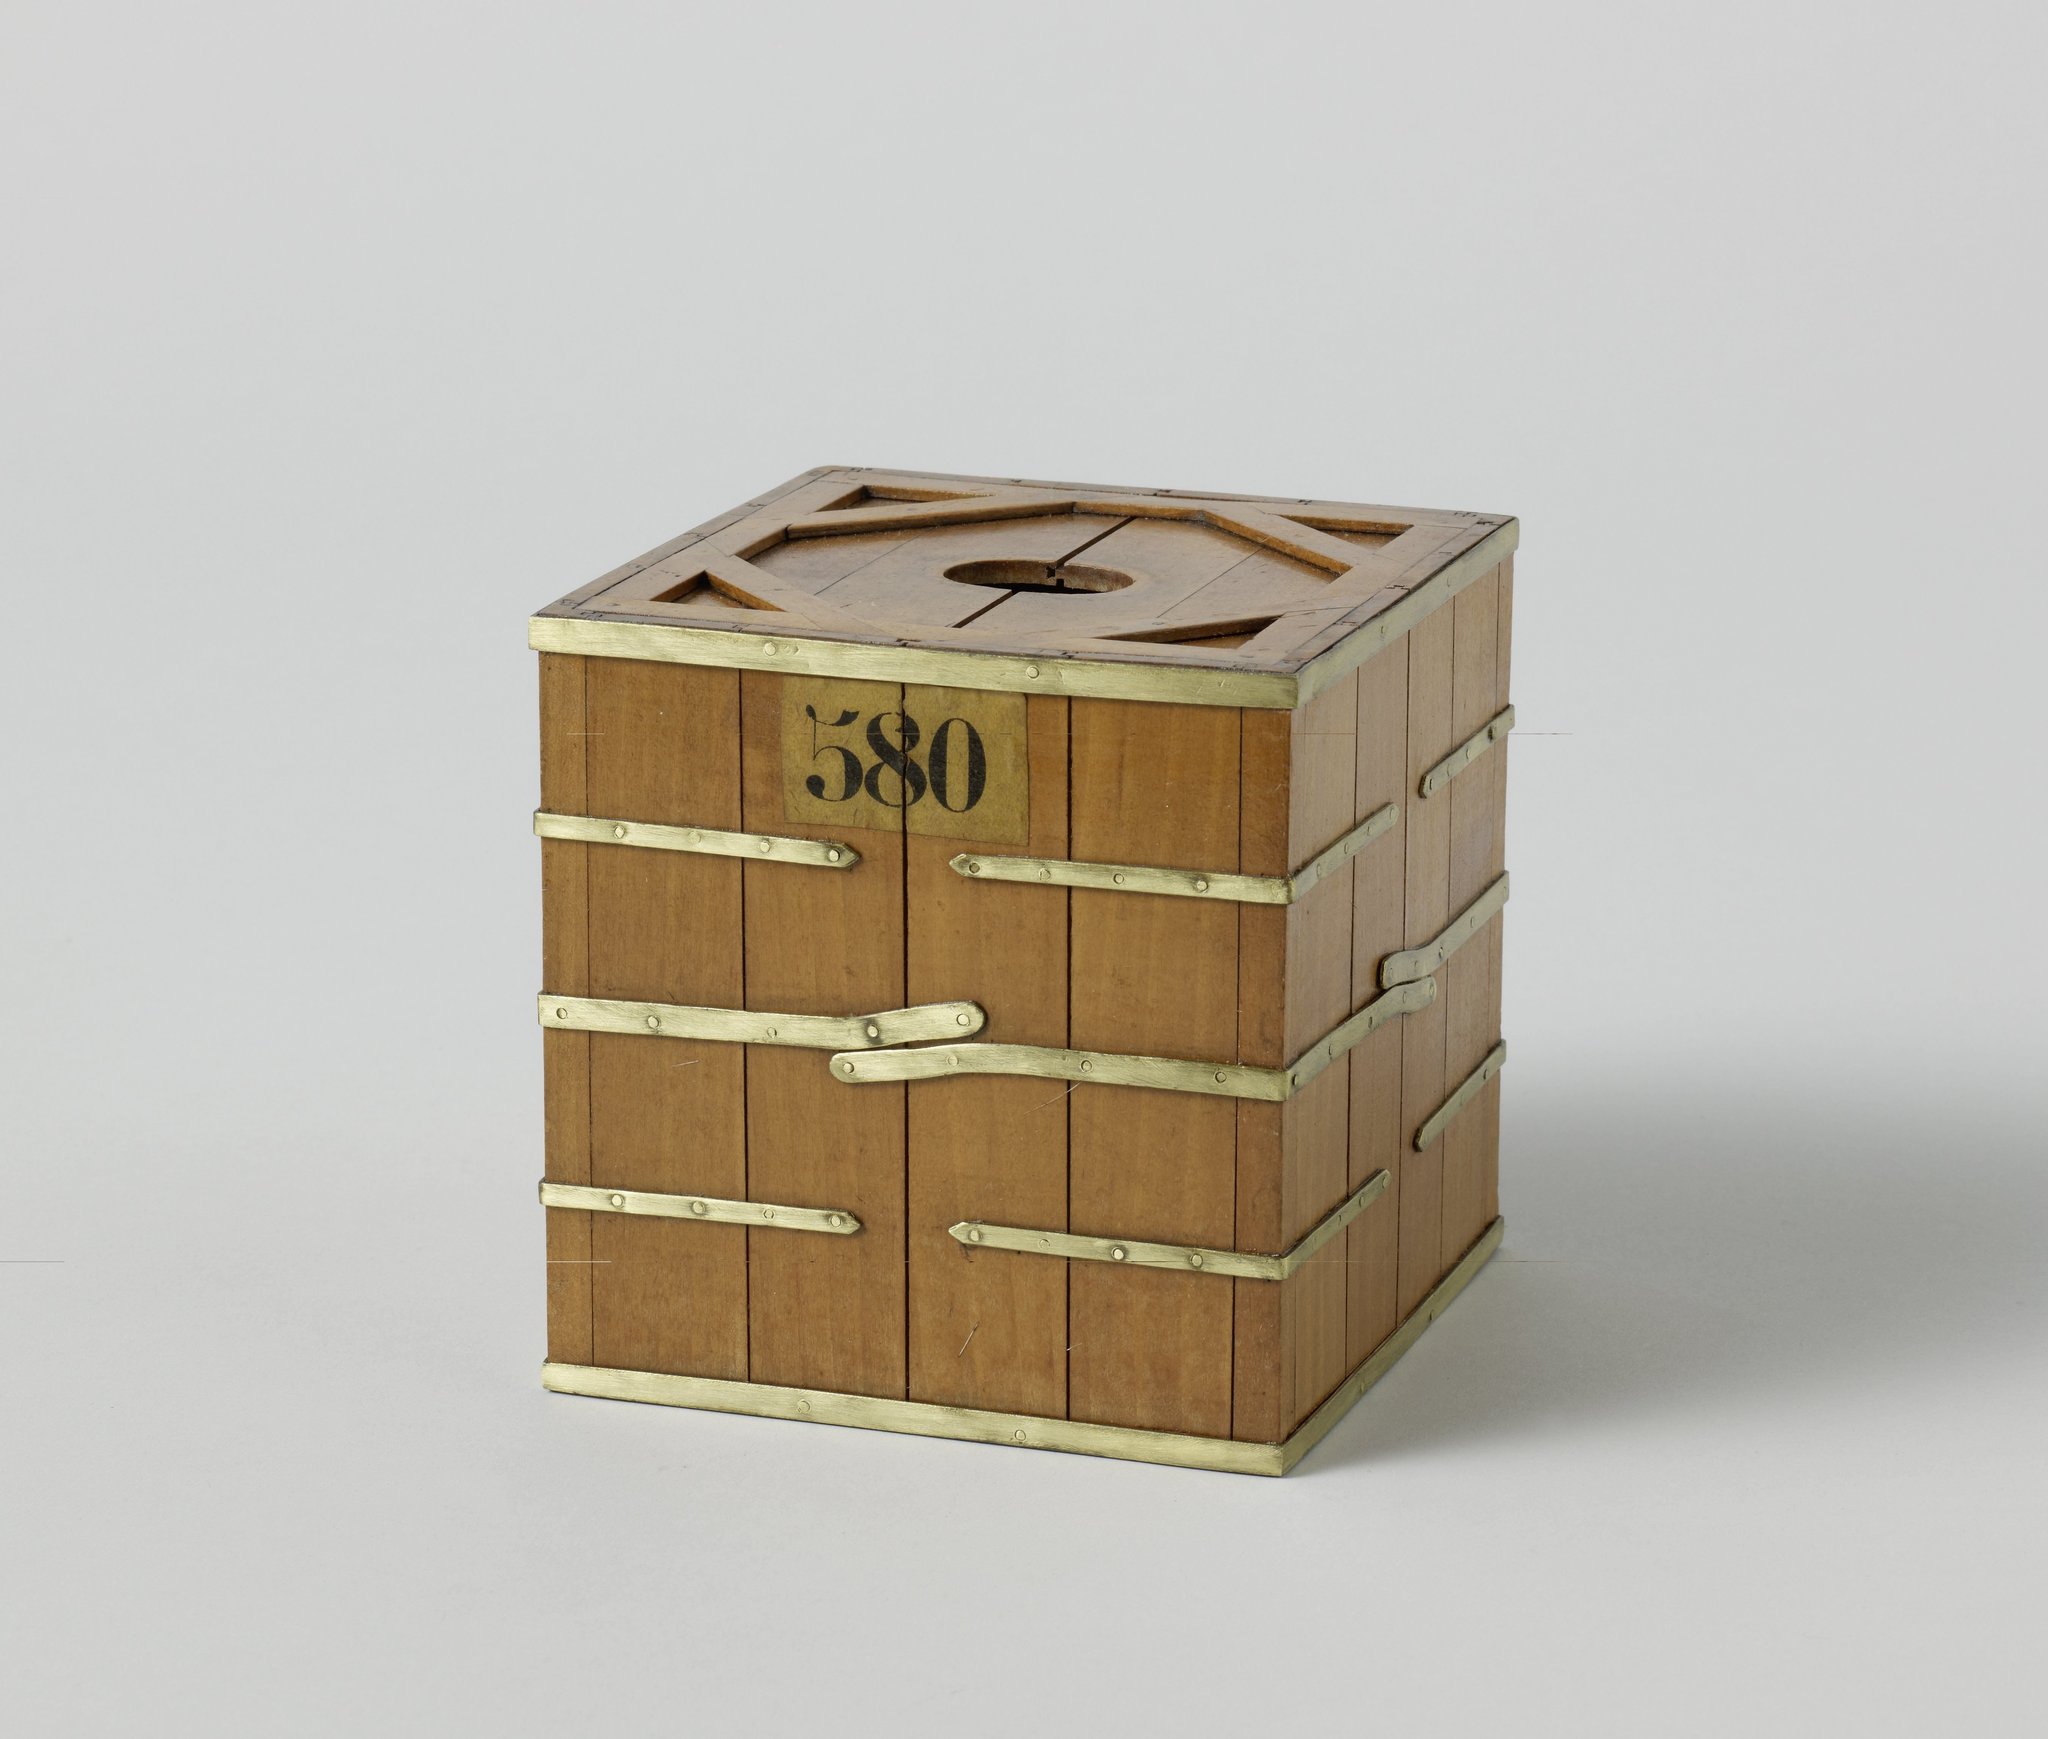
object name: demonstration model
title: Model of a Water Tank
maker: j.r. baartmans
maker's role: model maker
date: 1844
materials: brass, wood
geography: vlissingen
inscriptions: label, top: ‘580’ former inventory label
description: J.R. Baartmans was commandeur der kuipers op de Rijkswerf te Vlissingen. In 1844 verkreeg hij octrooi voor zijn uitvinding van houten waterkisten, waarvan hij twee types voorstelde: vierkante (kubusvormige) en driehoekige. De voornaamste voordelen waren de lage kosten en het geringe gewicht. Zij konden eenvoudig uit elkaar genomen worden en weer in elkaar gezet, en trokken spoedig na vulling dicht. De driehoekige echter waren minder waterdicht en namen te veel plaats in.